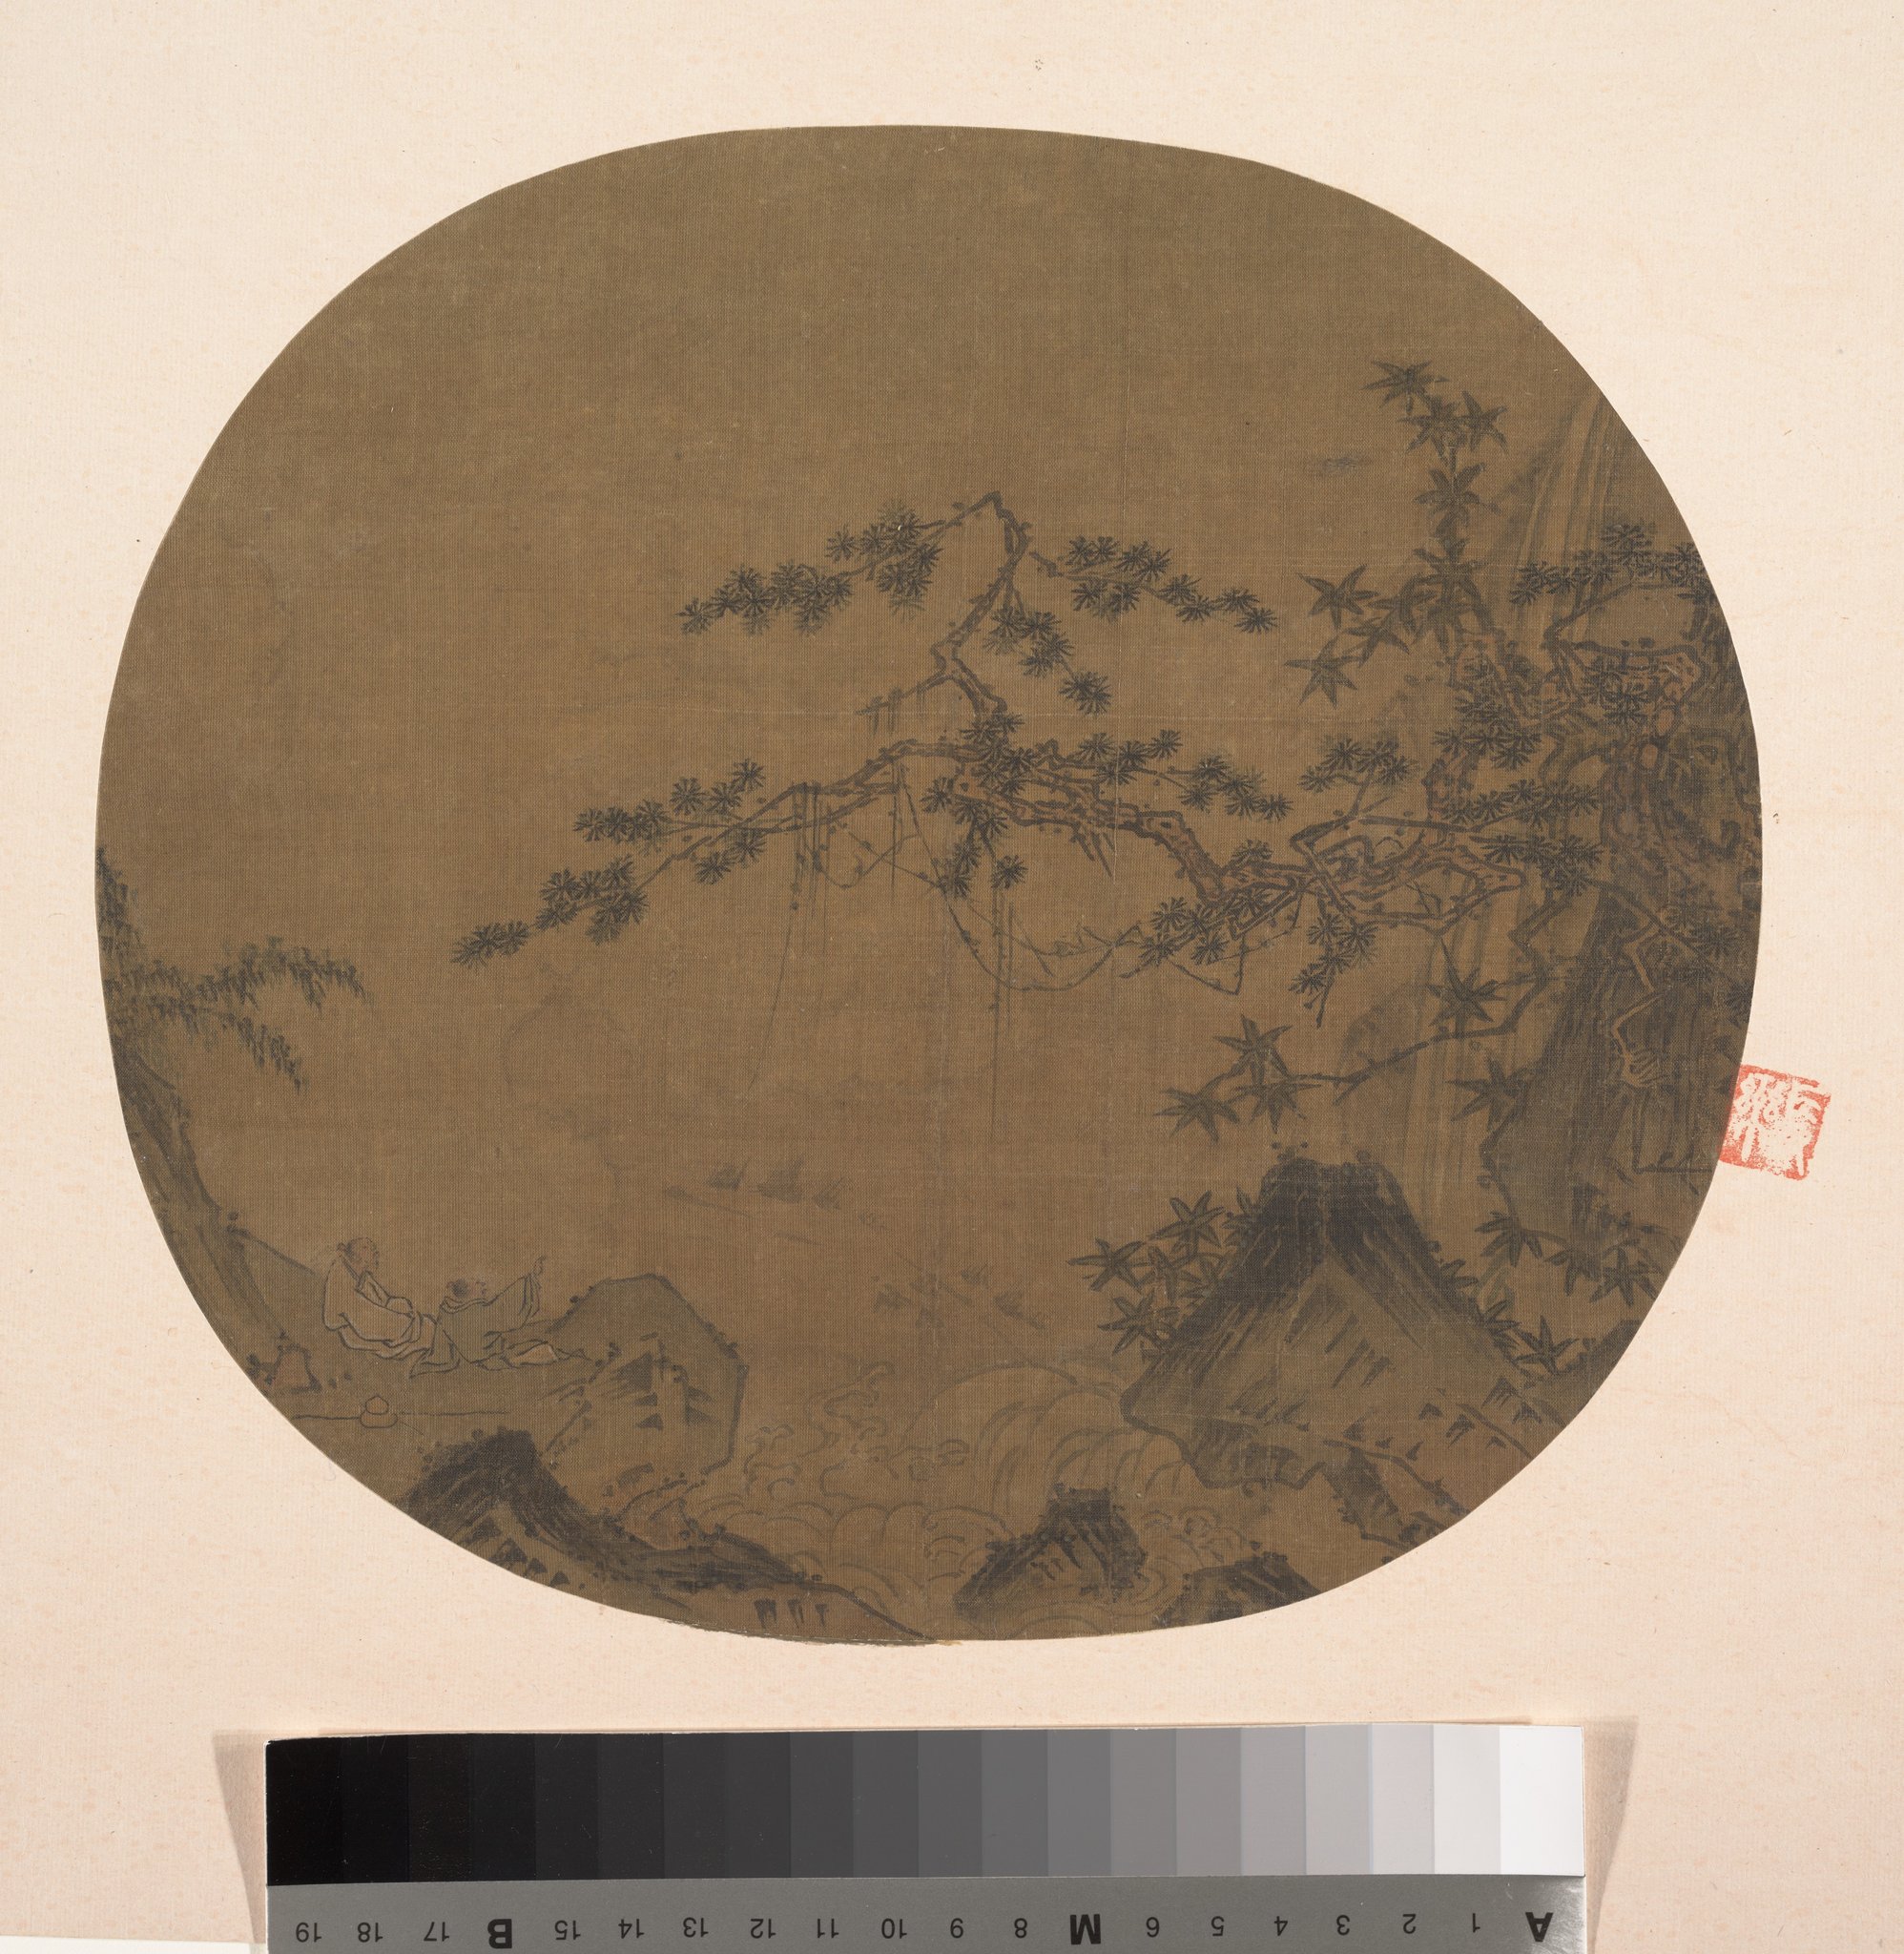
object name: fan mounted a an album leaf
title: Sages Admiring Waterfall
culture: chinese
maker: unidentified artist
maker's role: artist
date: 1368-1644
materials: ink, silk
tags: men,waterfalls,landscapes